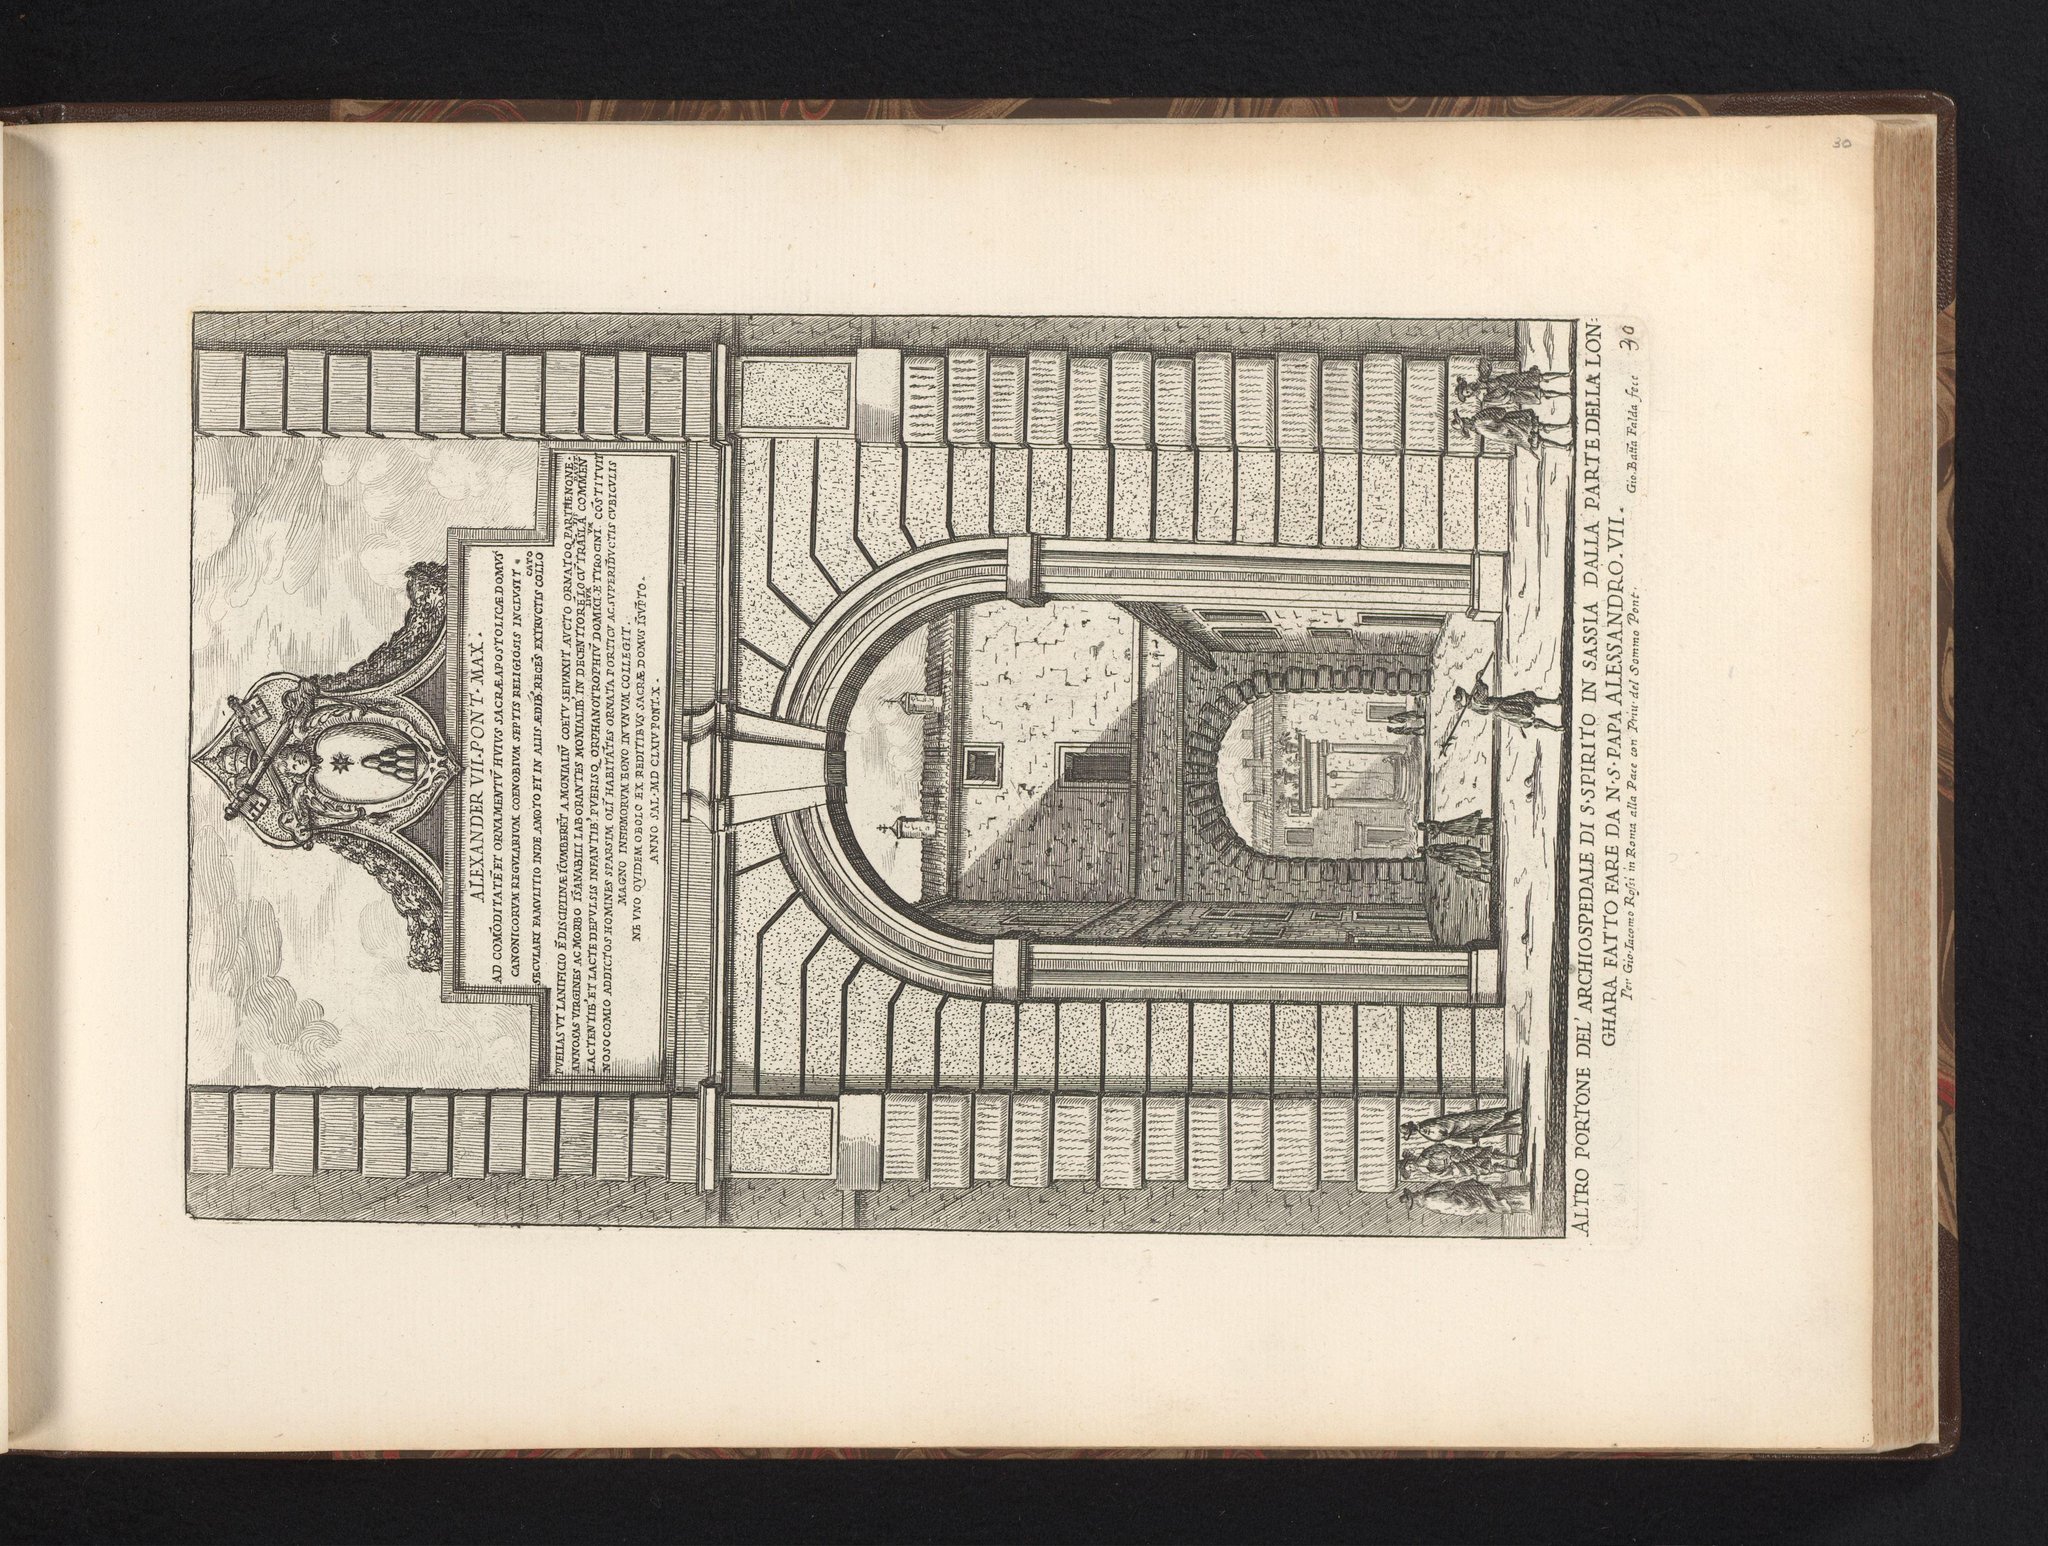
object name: print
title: Ingangspoort van het Arcispedale di San Spirito in Saxia te Rome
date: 1665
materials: paper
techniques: etching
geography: italy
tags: city-view, and landscape with man-made constructions, gate, entrance, hospital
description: Deze prent maakt deel uit van een reeks van 35 prenten met voorstellingen van gebouwen in Rome. Samen met vier andere reeksen vormt het de grote reeks: 'Il nuovo teatro di Roma moderna'.